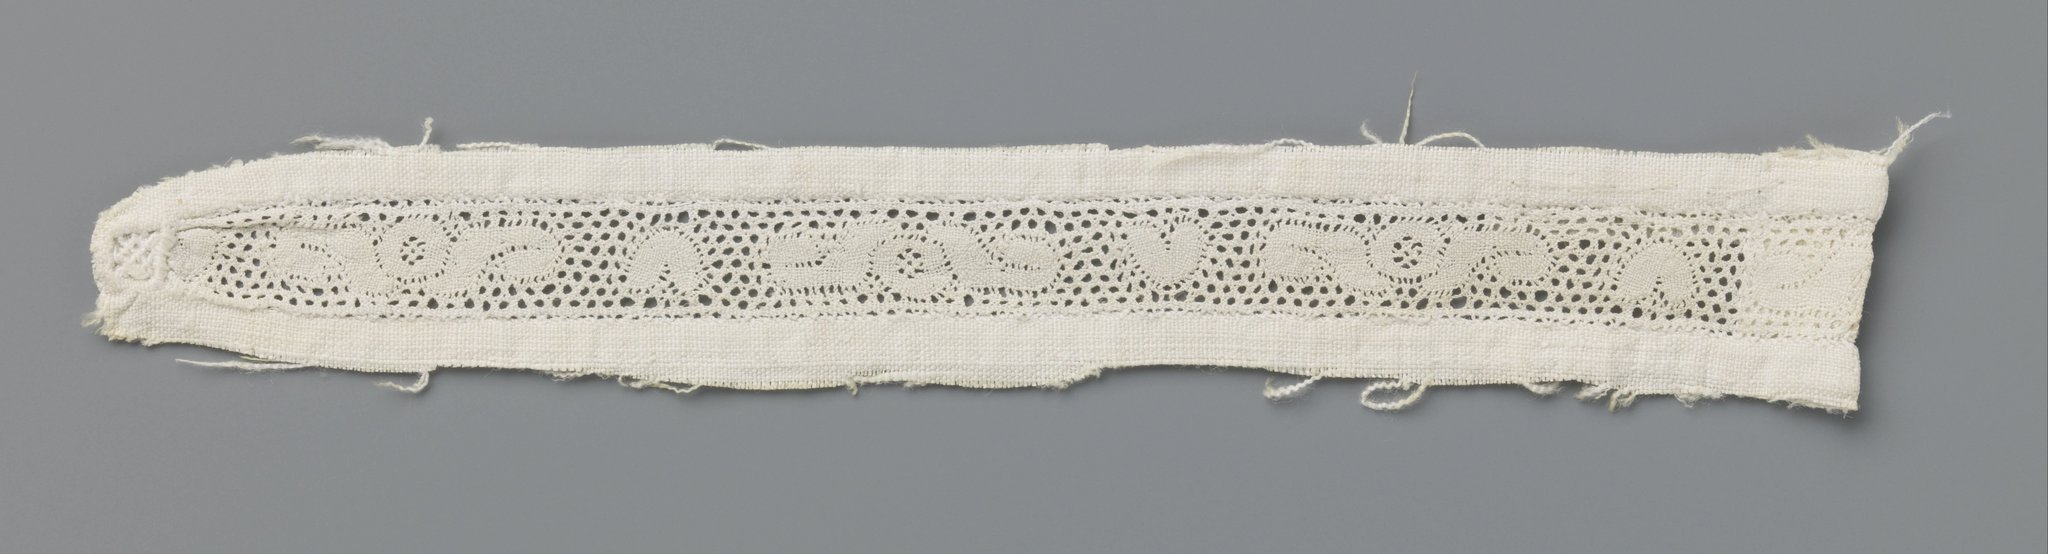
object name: entre deux, tussenzetsel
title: Tussenzetsel van kloskant met hartje en rond bloempje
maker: Anonymous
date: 1640-1660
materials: linen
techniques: lace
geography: antwerp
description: Tussenzetsel van naturelkleurige Hollandse kloskant. Het zich herhalende patroon bestaat afwisselend uit een hartje en een rond bloempje tussen twee langgerekte omkrullende bladeren. Het hartje staat afwisselend rechtop en omgekeerd. De motieven zijn met elkaar verbonden door een ronde traliegrond met vlechtslagen. De motieven zijn gemaakt in linnenslag met opengewerkte randjes en uitsparingen in het cirkelvormige bloemhart. Boven- en onderzijde van de strook zijn recht afgewerkt en vastgenaaid aan een fragment linnen afkomstig van een sloop.